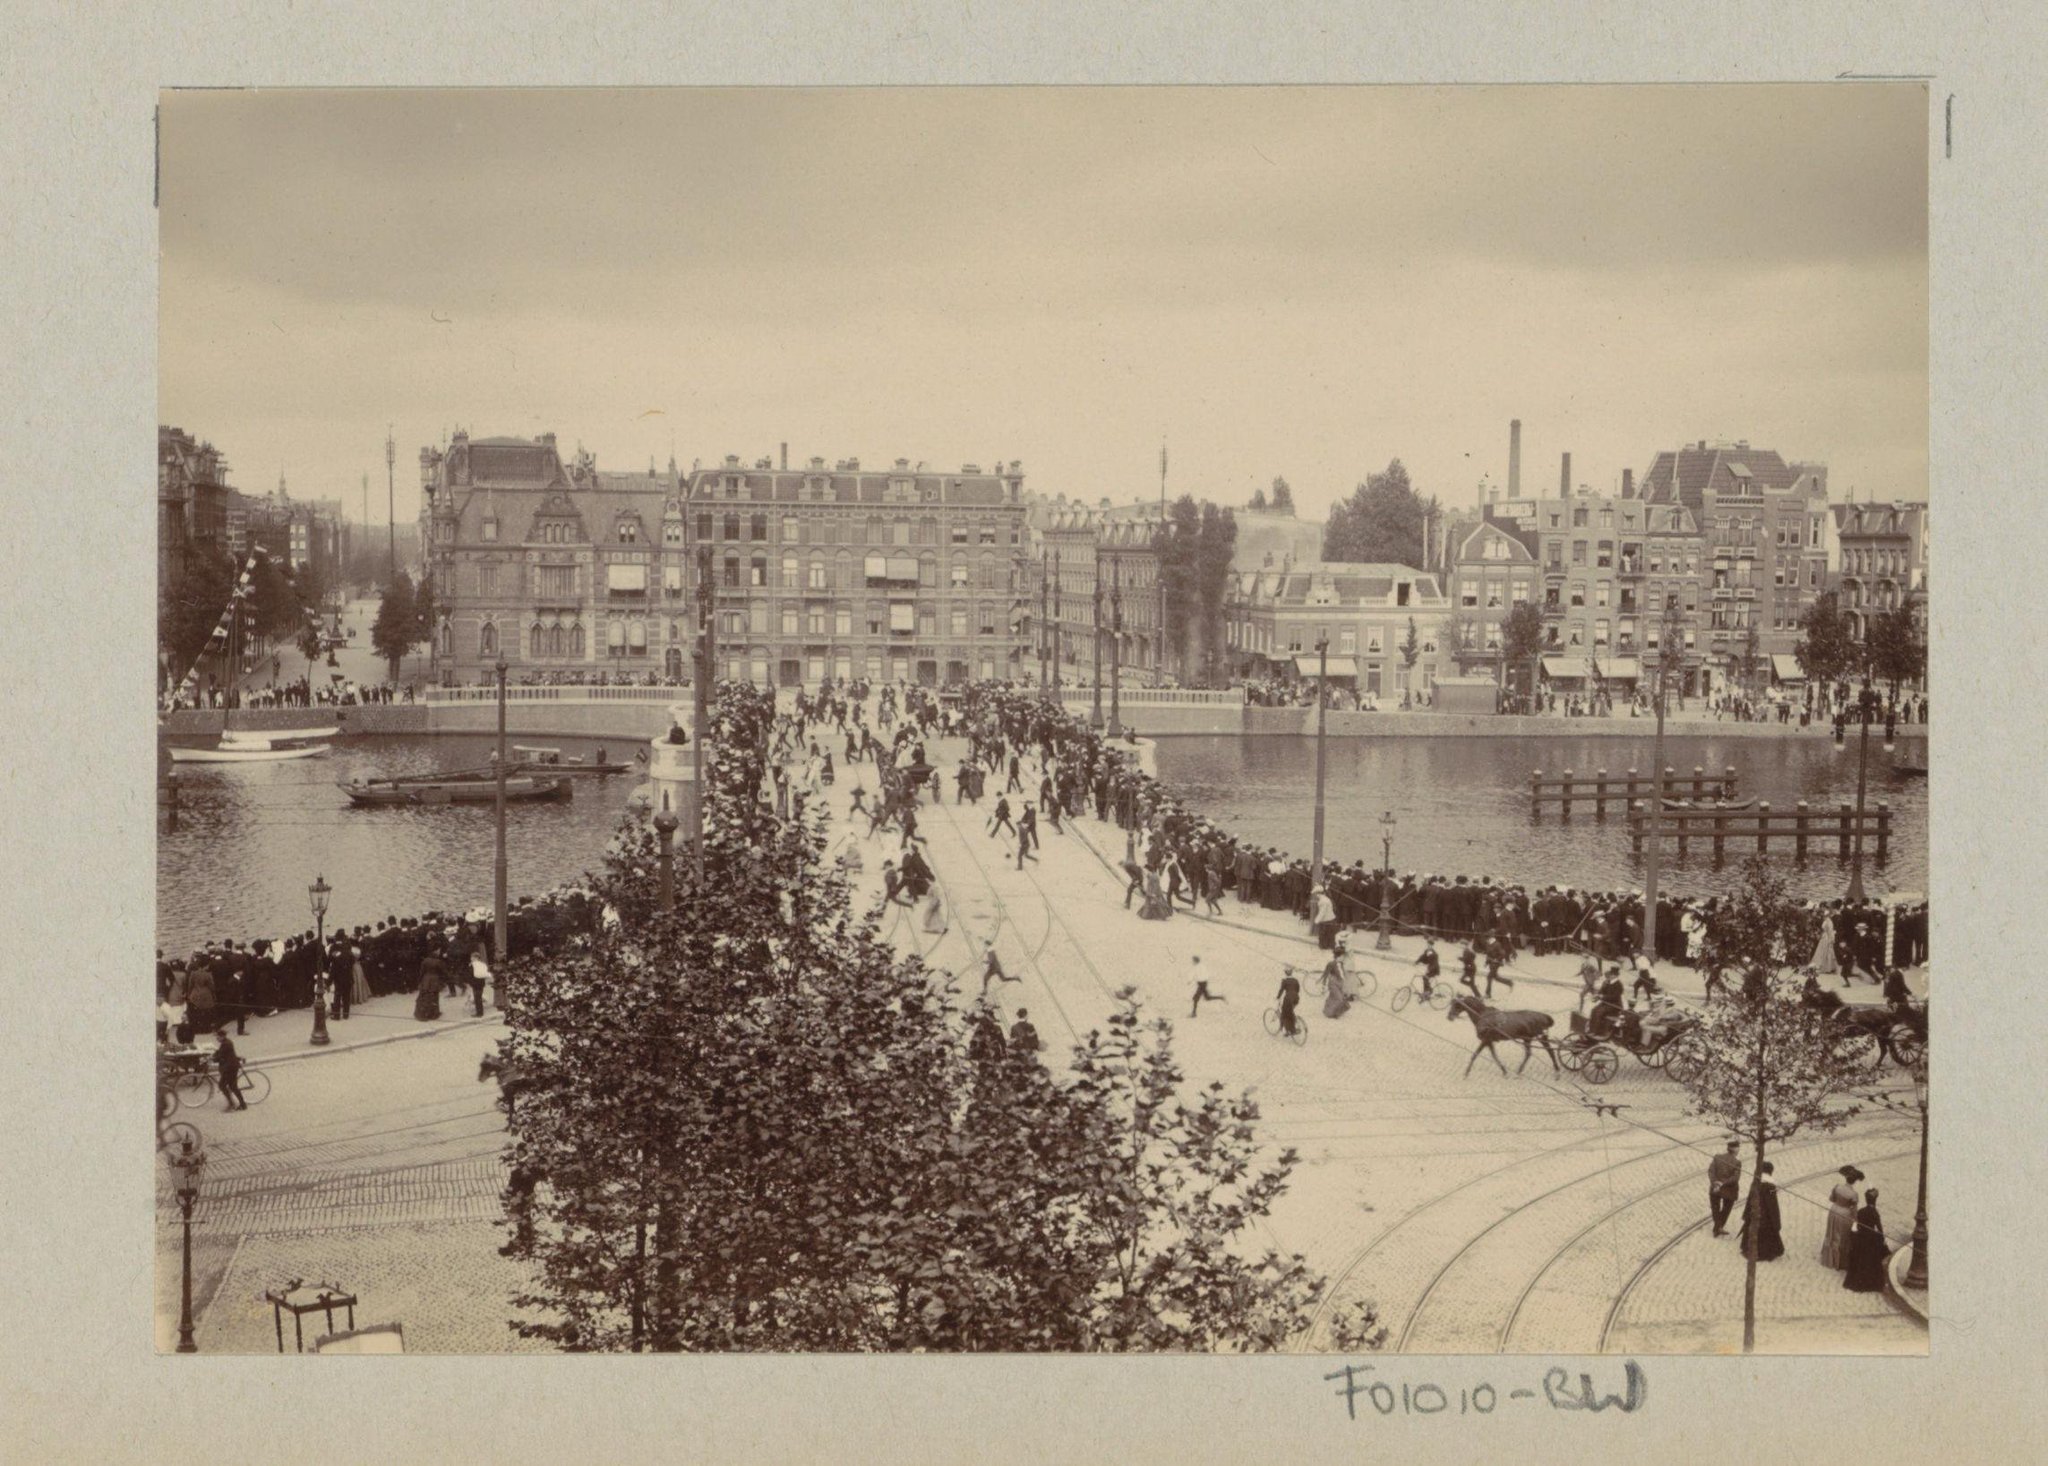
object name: photograph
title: Drukte op de Nieuwe Amstelbrug, gezien richting Amsterdam-Oost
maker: Anonymous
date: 1903-1910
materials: photographic support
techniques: gelatin silver print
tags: tramway, tram, river, bridge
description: Onderdeel van Familiealbum met onder meer foto's van Wijnhandel Kraaij & Co. Bordeaux-Amsterdam.